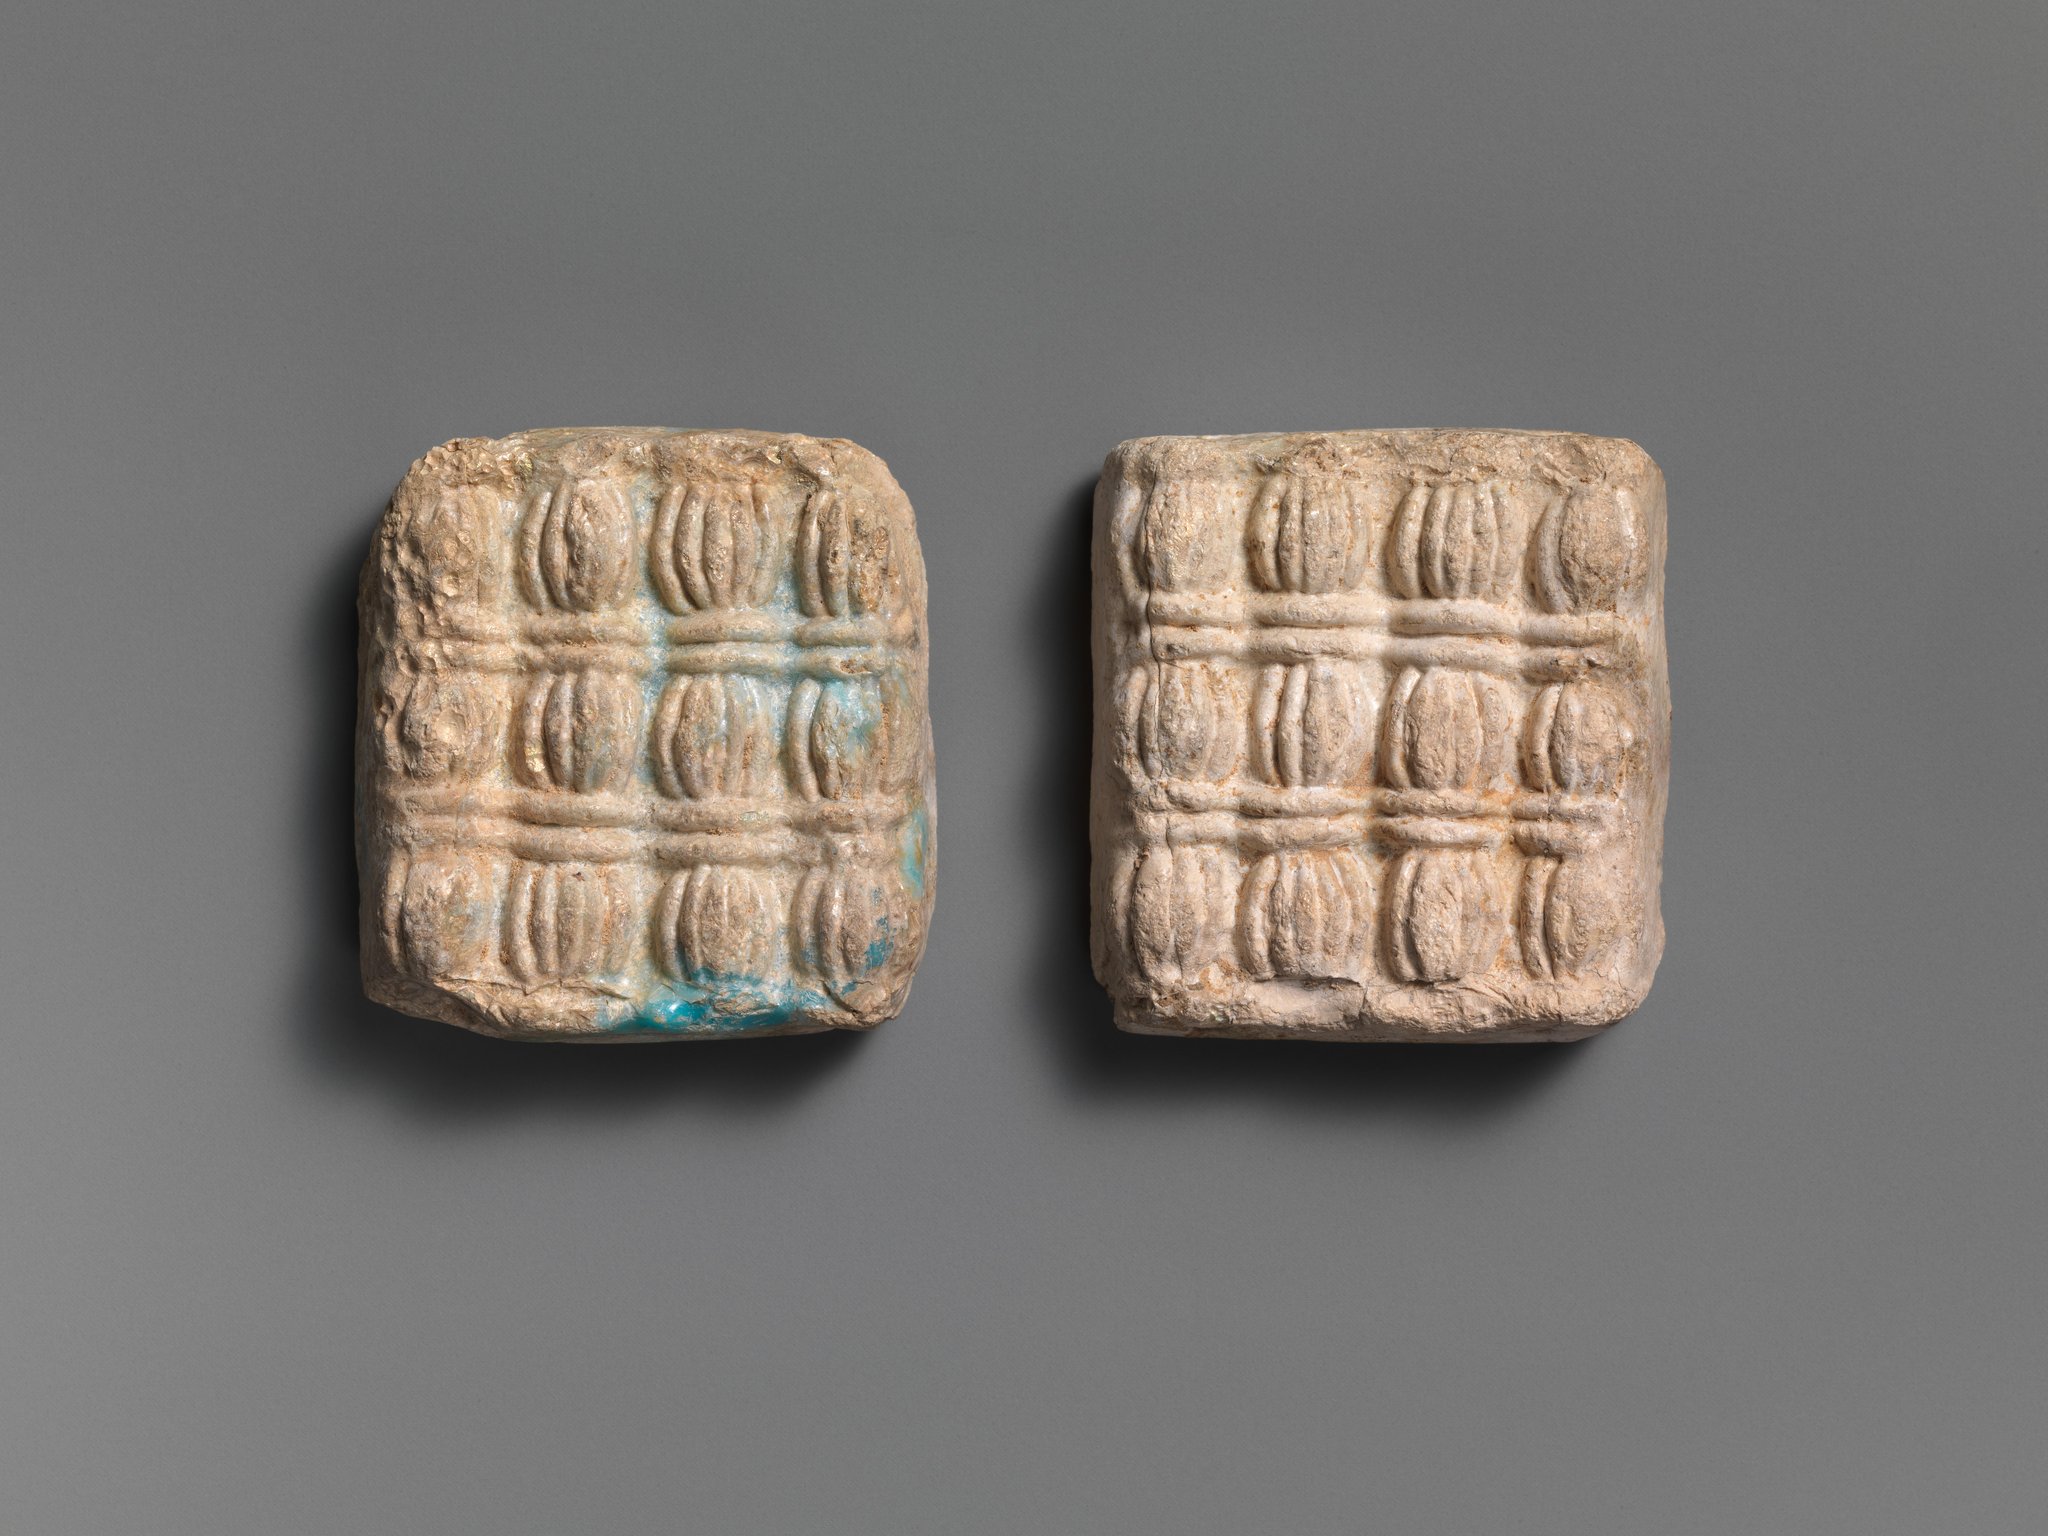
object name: bead, grooved into one piece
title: Glass bead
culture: levantine or western asiatic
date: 1500-1350 BCE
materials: glass